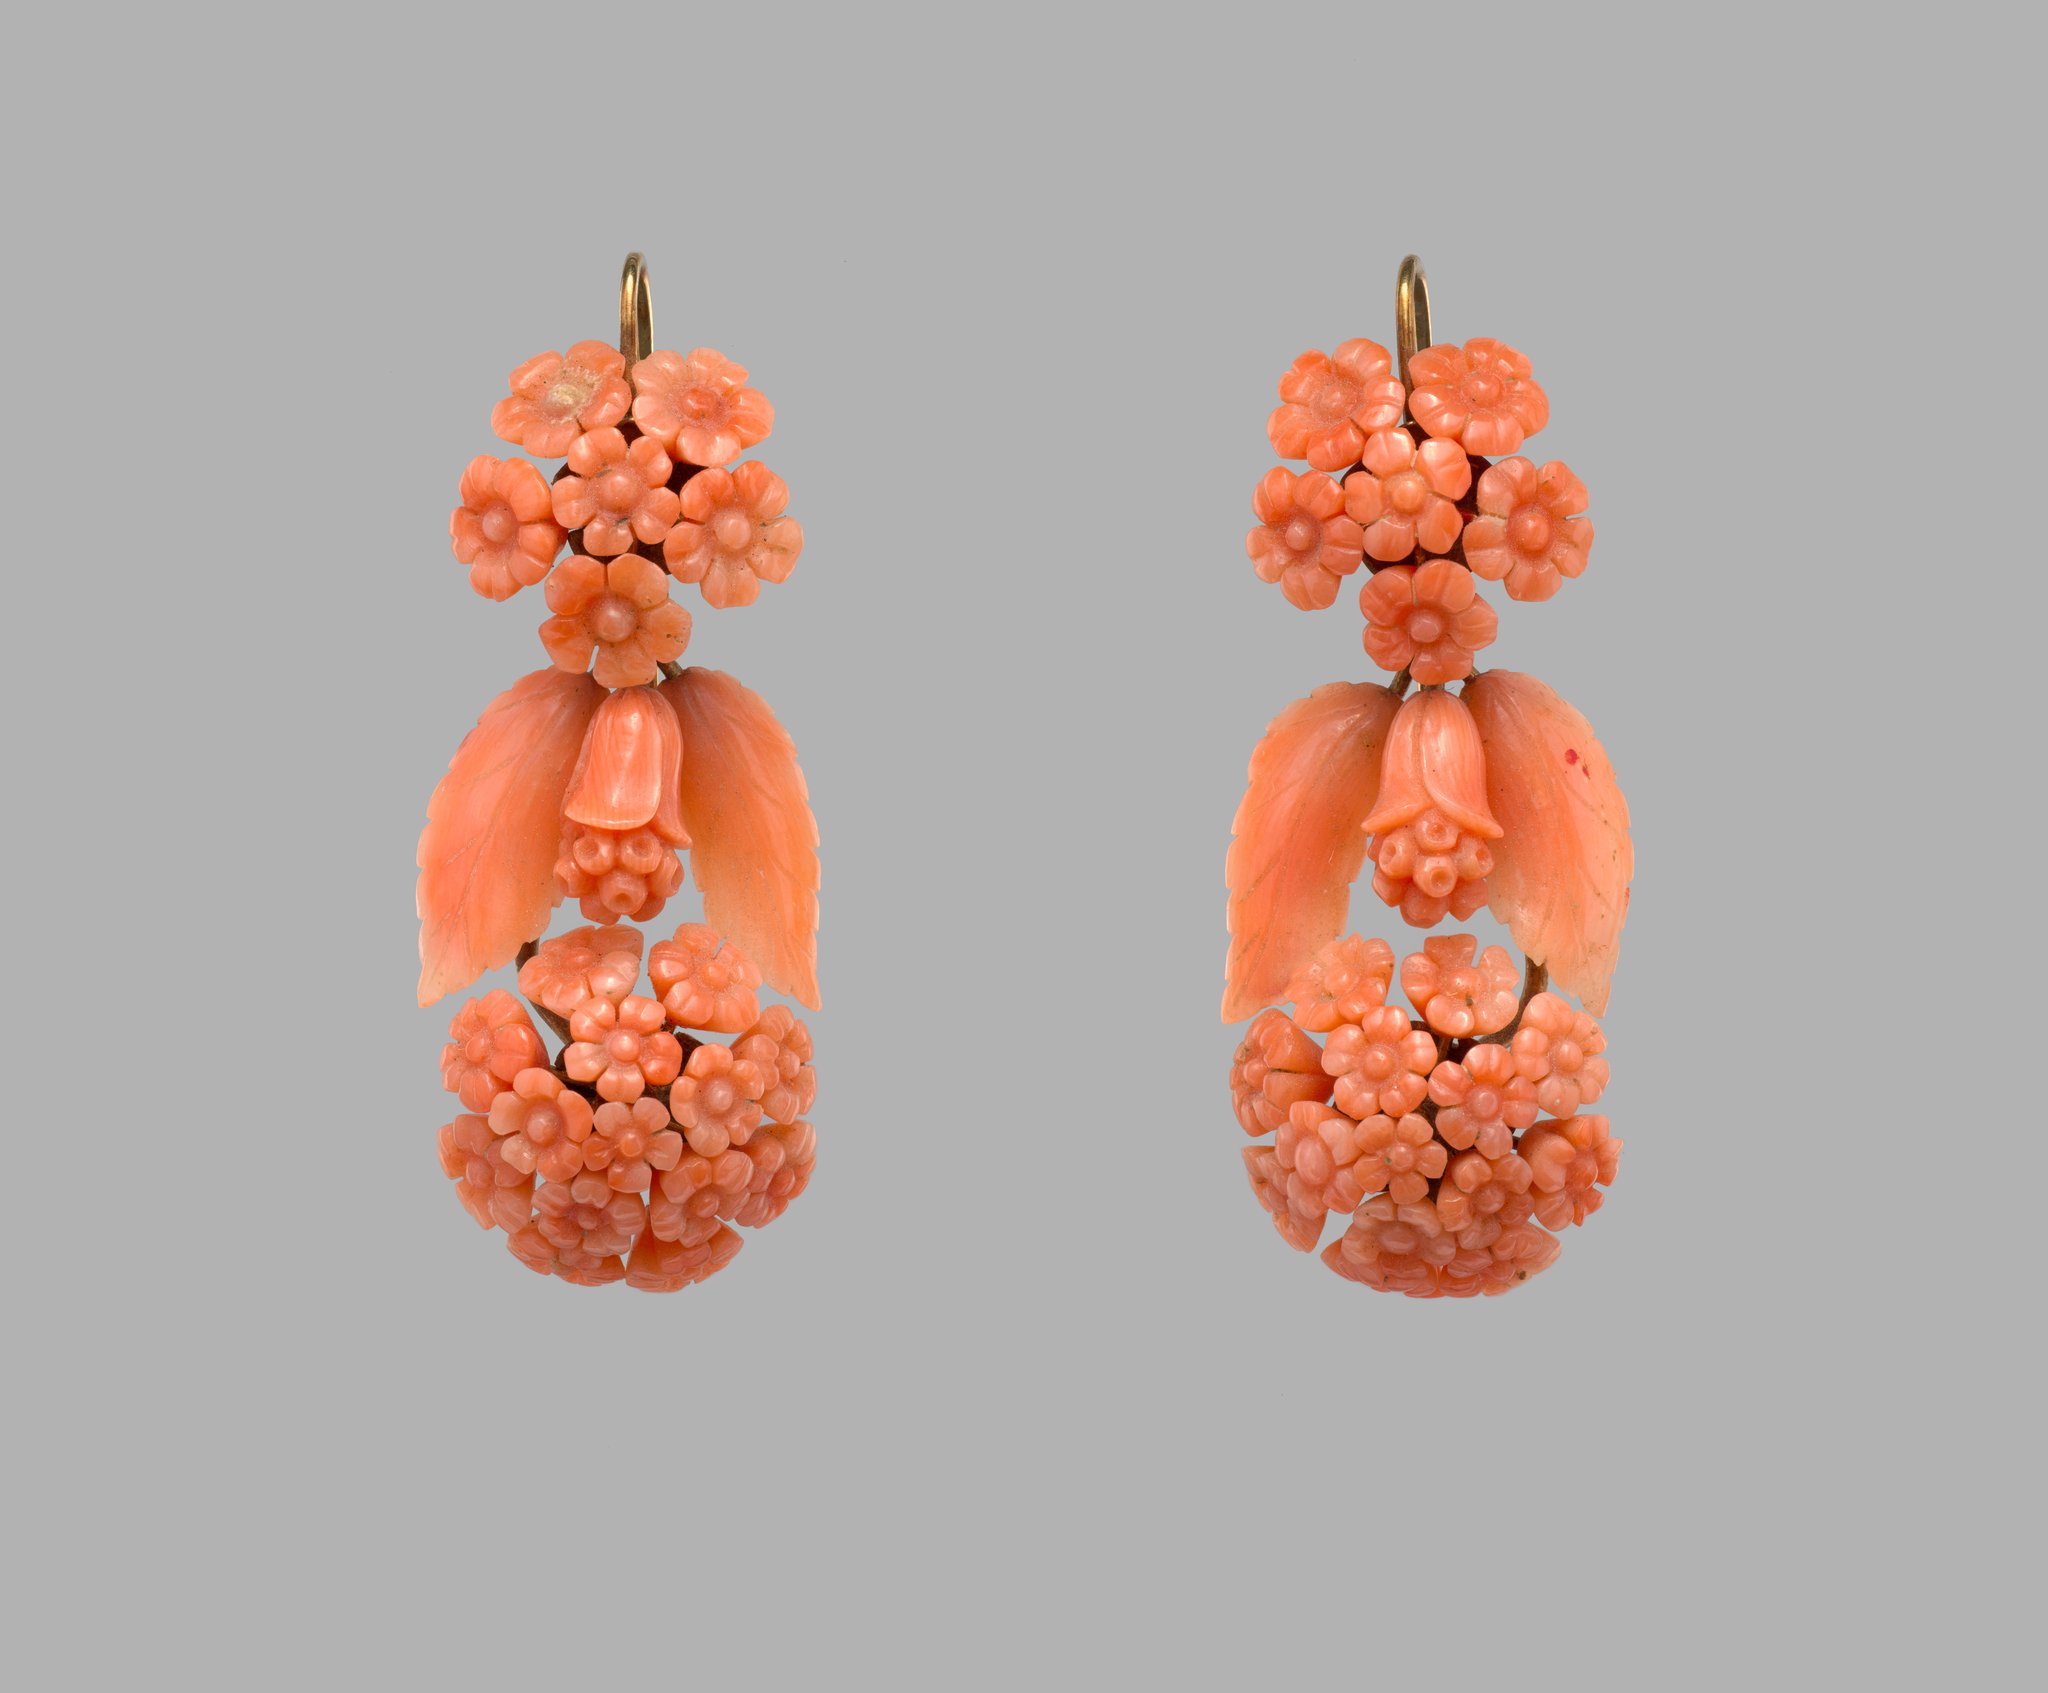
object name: earring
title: Earring (part of parure)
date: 1860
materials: coral, gold